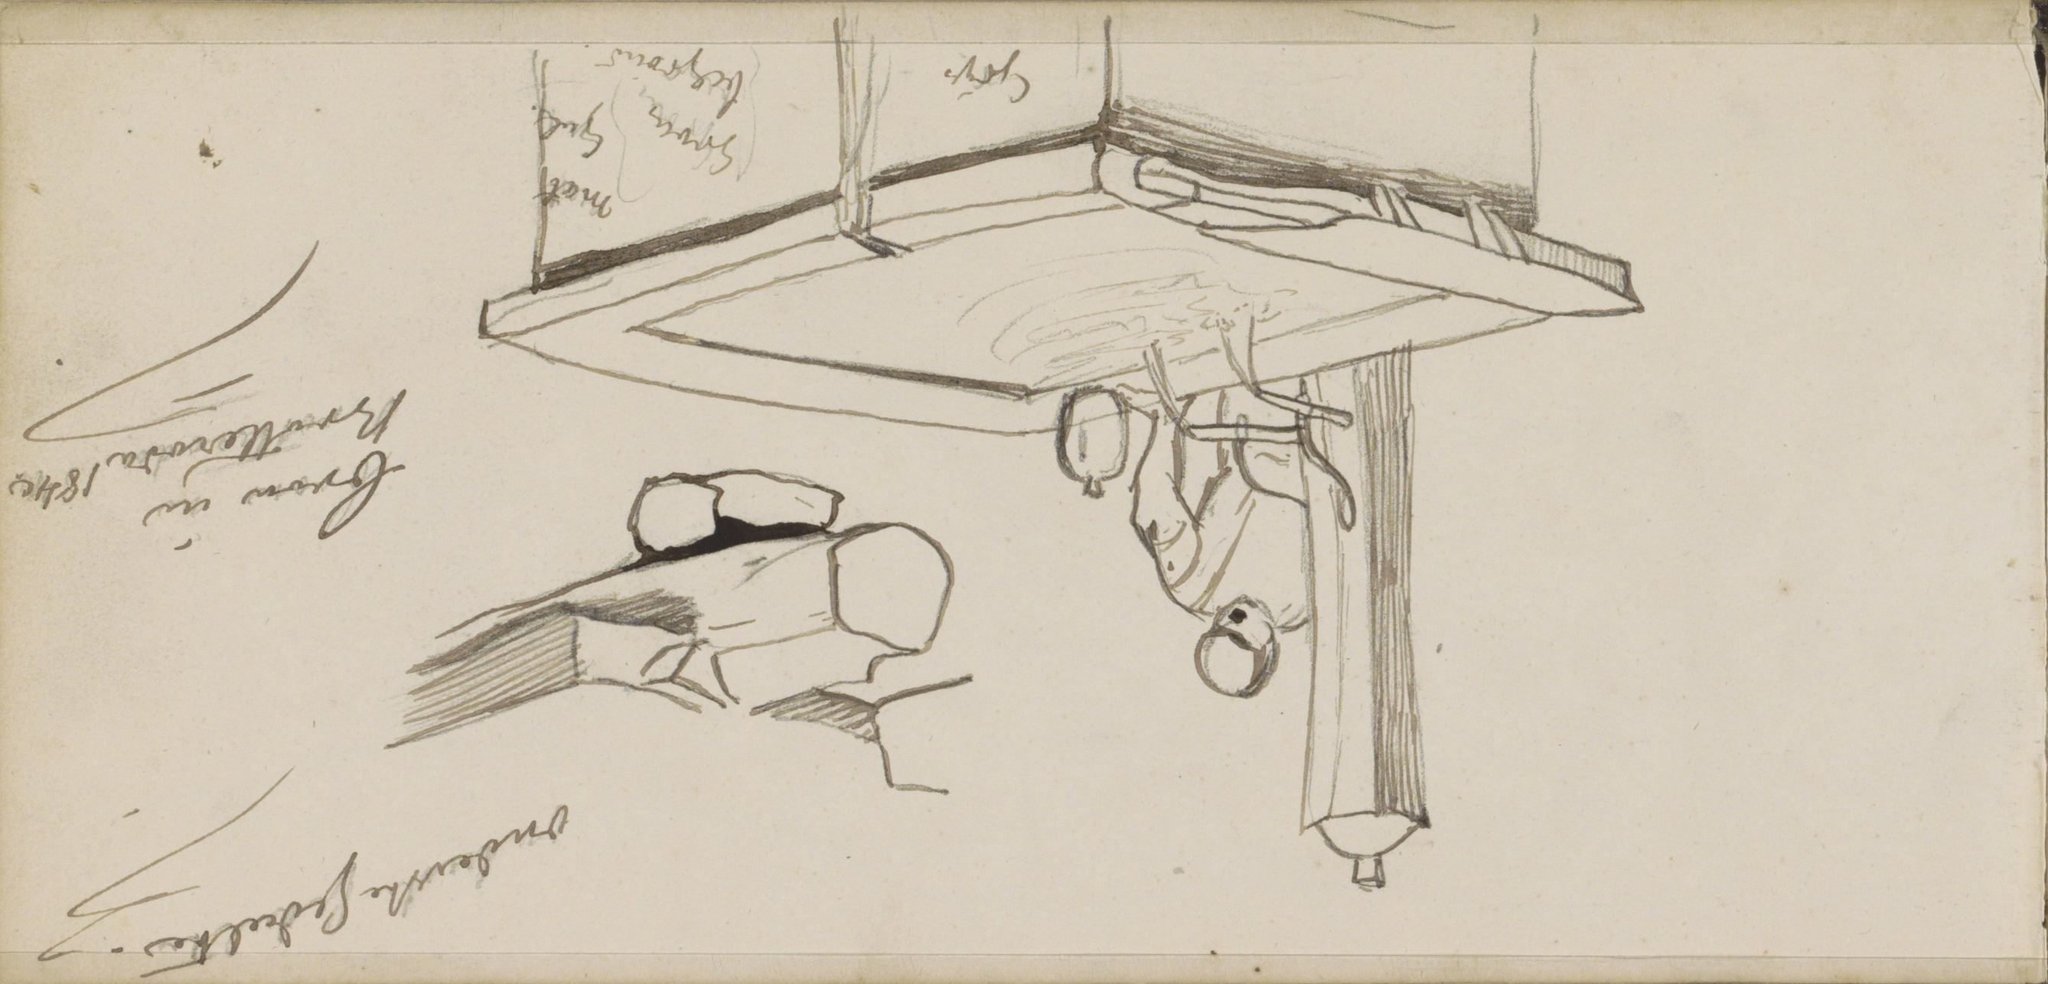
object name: sketchbook leaf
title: Man bij een bron in Brotterode in Thüringen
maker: johannes tavenraat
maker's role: draughtsman, painter, print maker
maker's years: 1809-1881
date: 1840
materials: ink, paper, pencil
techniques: pen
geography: schwarzburg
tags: well, standing figure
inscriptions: date and inscription: ‘onderste gedeelte/ bron in/ Brotteroda 1840’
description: Blad 59 verso uit een schetsboek met 63 bladen.